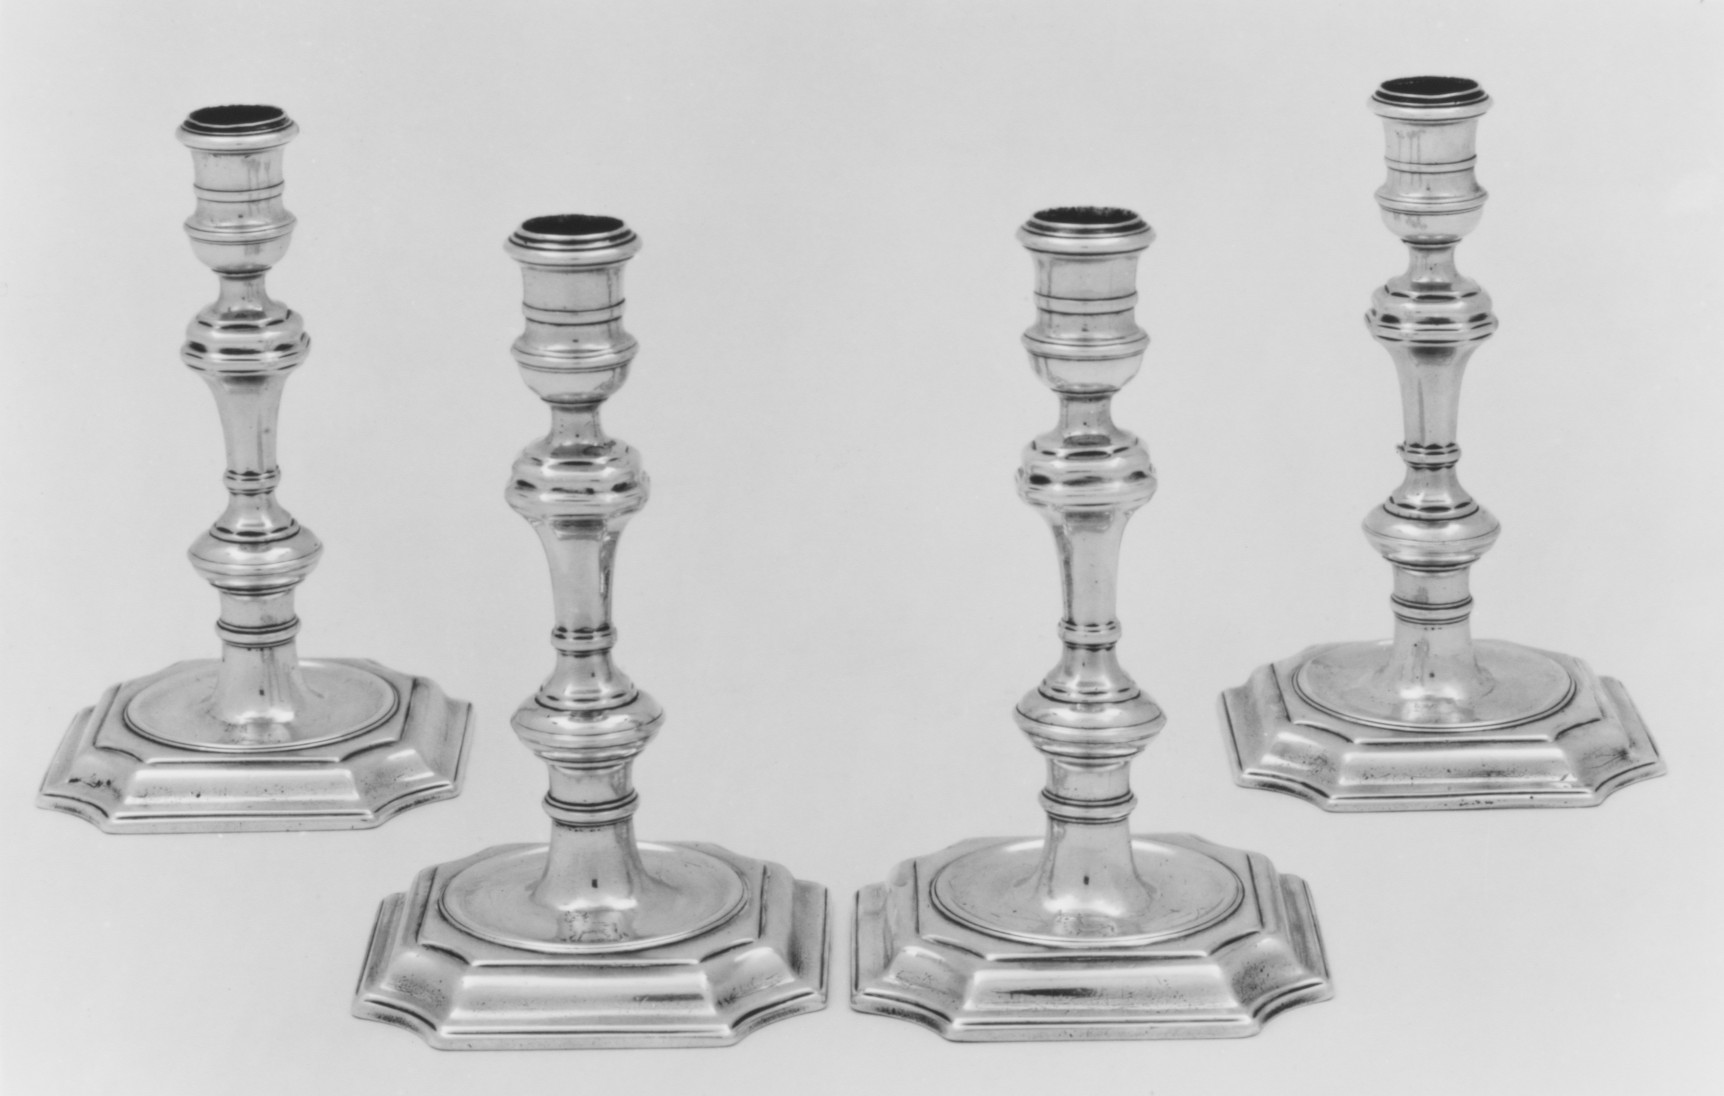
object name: candlestick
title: Set of four candlesticks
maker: paul de lamerie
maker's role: maker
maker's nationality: british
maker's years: 1688-1751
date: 1728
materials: silver